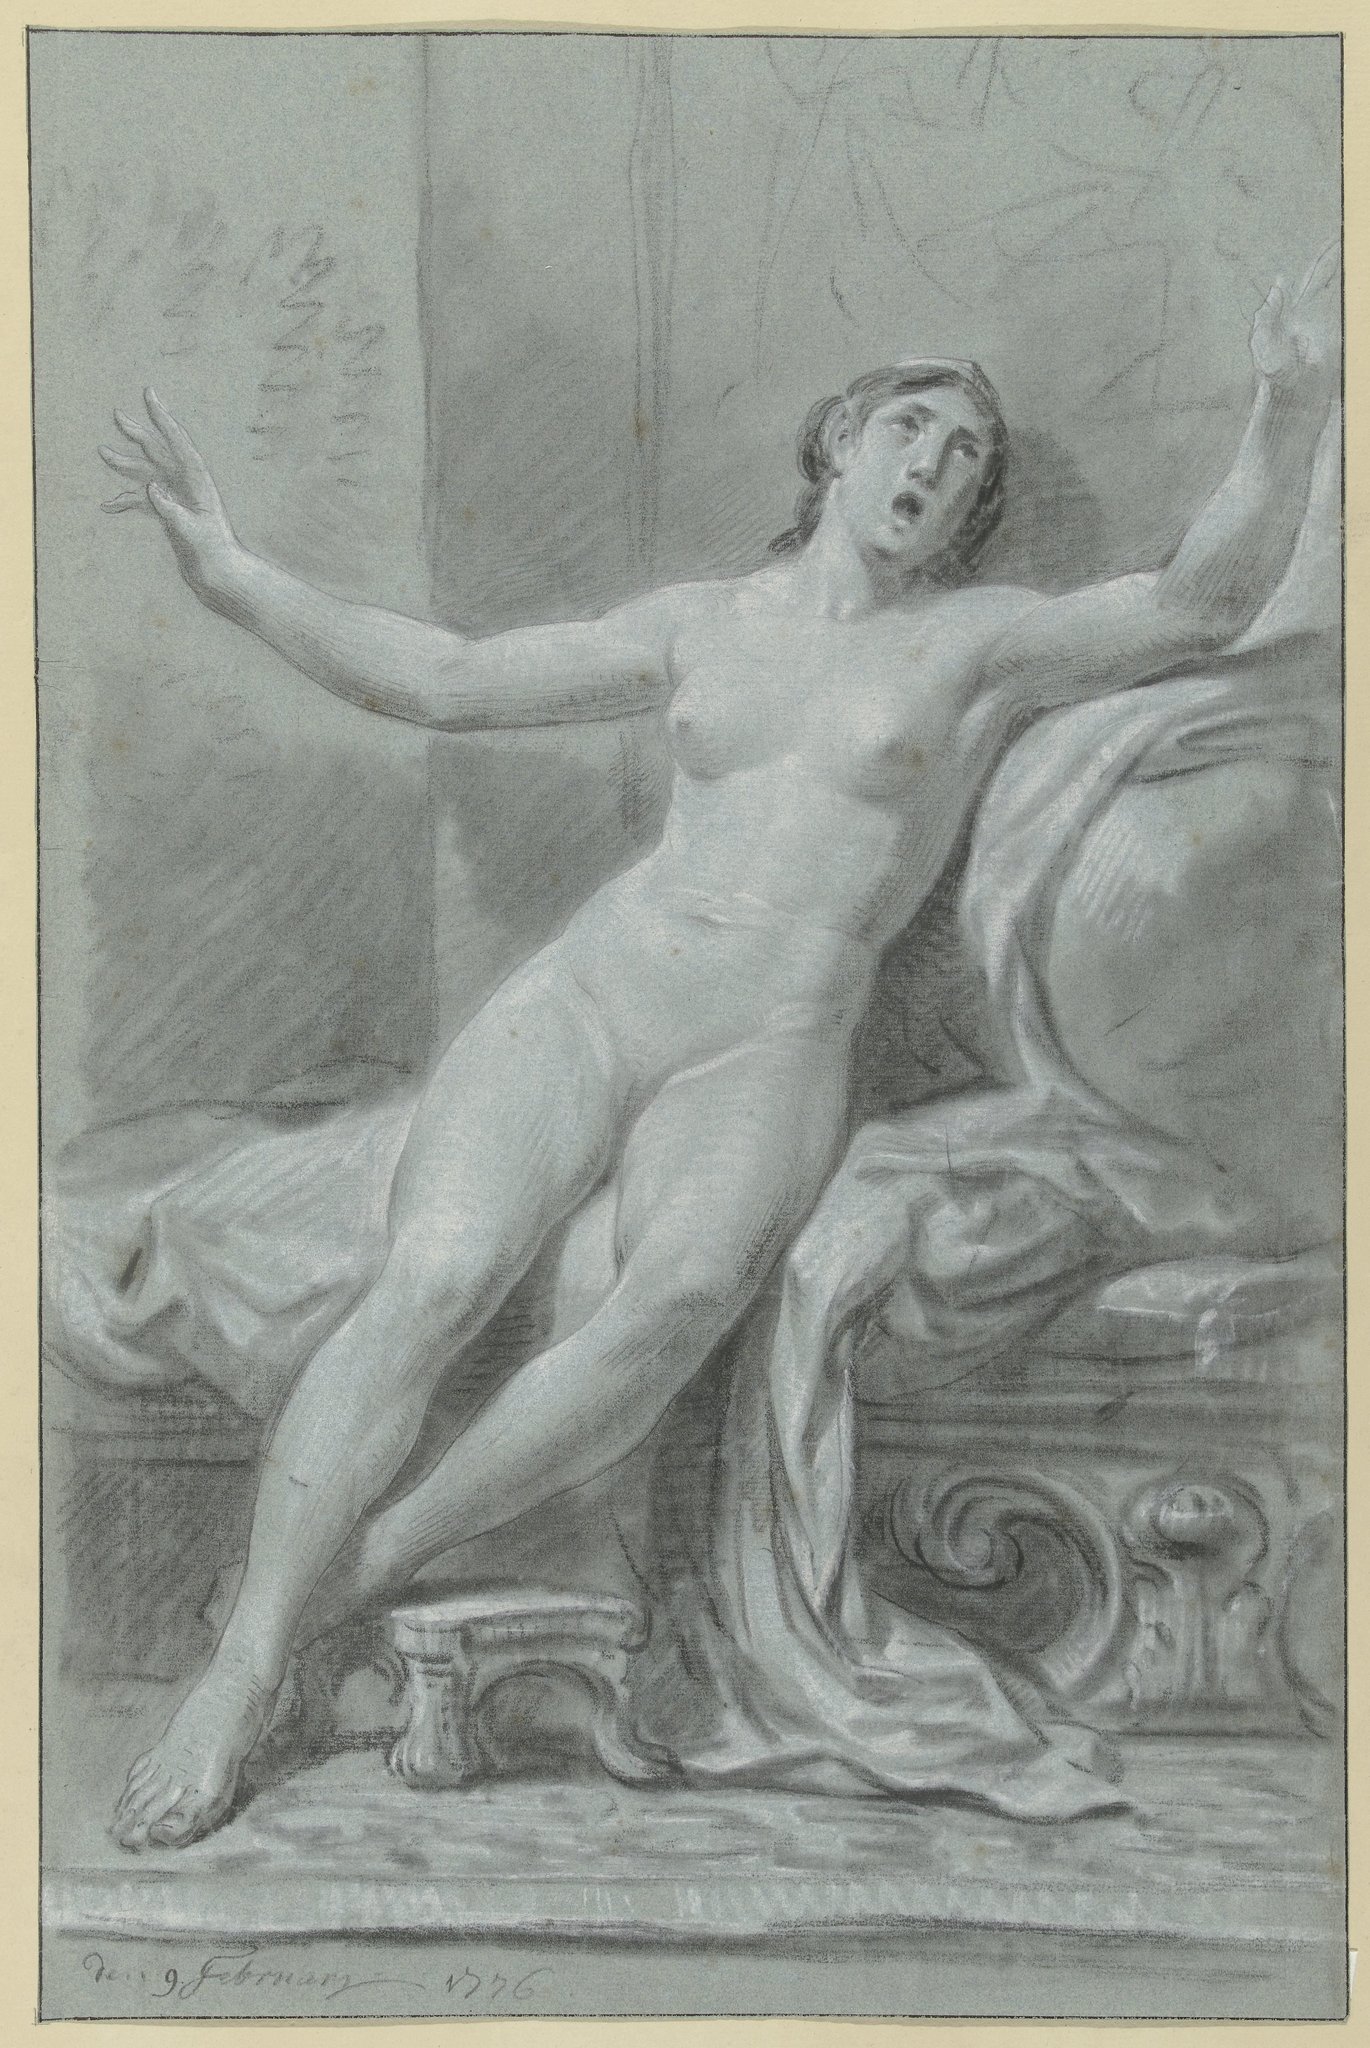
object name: drawing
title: Seated Female Nude, with Raised Arms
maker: jean grandjean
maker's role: draughtsman, print maker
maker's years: 1752-1781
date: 1776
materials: chalk, paper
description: In these studies Grandjean strictly followed the prevailing guidelines for drawing a model. For instance, he used black and white chalk on blue paper to achieve finer tonal nuances. And, he situated his models in an imaginary setting. With their athletic build and theatrical bearing, these two nude models resemble ancient sculptures.